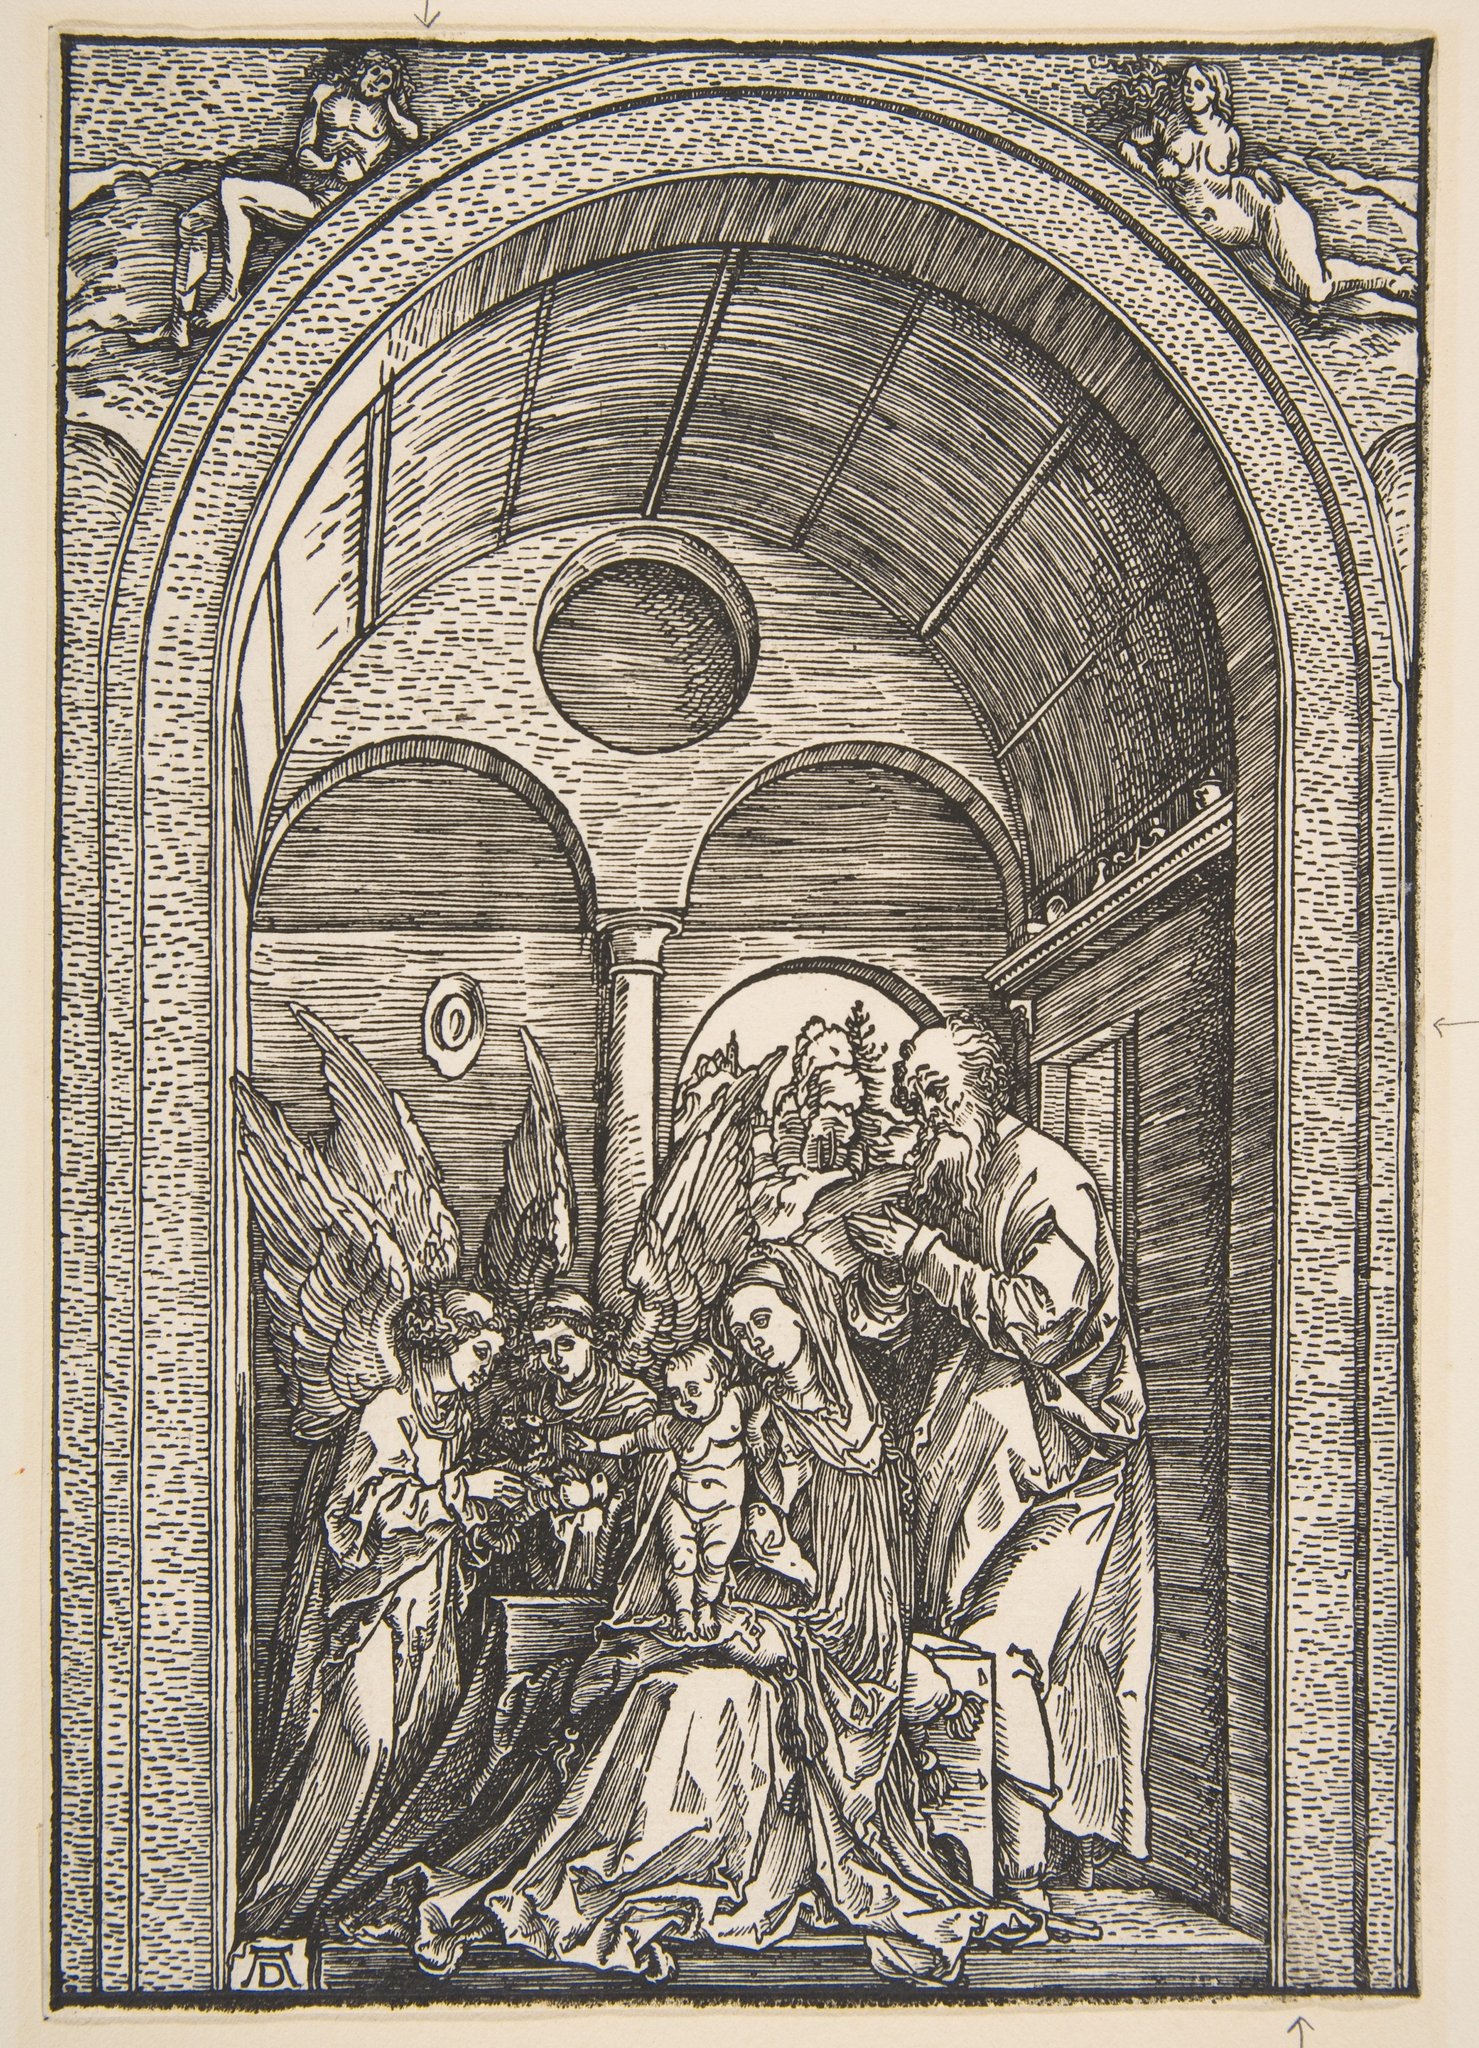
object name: print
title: The Holy Family with Two Angels in a Vaulted Hall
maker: albrecht dürer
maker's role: artist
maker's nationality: german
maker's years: 1471-1528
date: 1503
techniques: woodcut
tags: angels,holy family,madonna and child